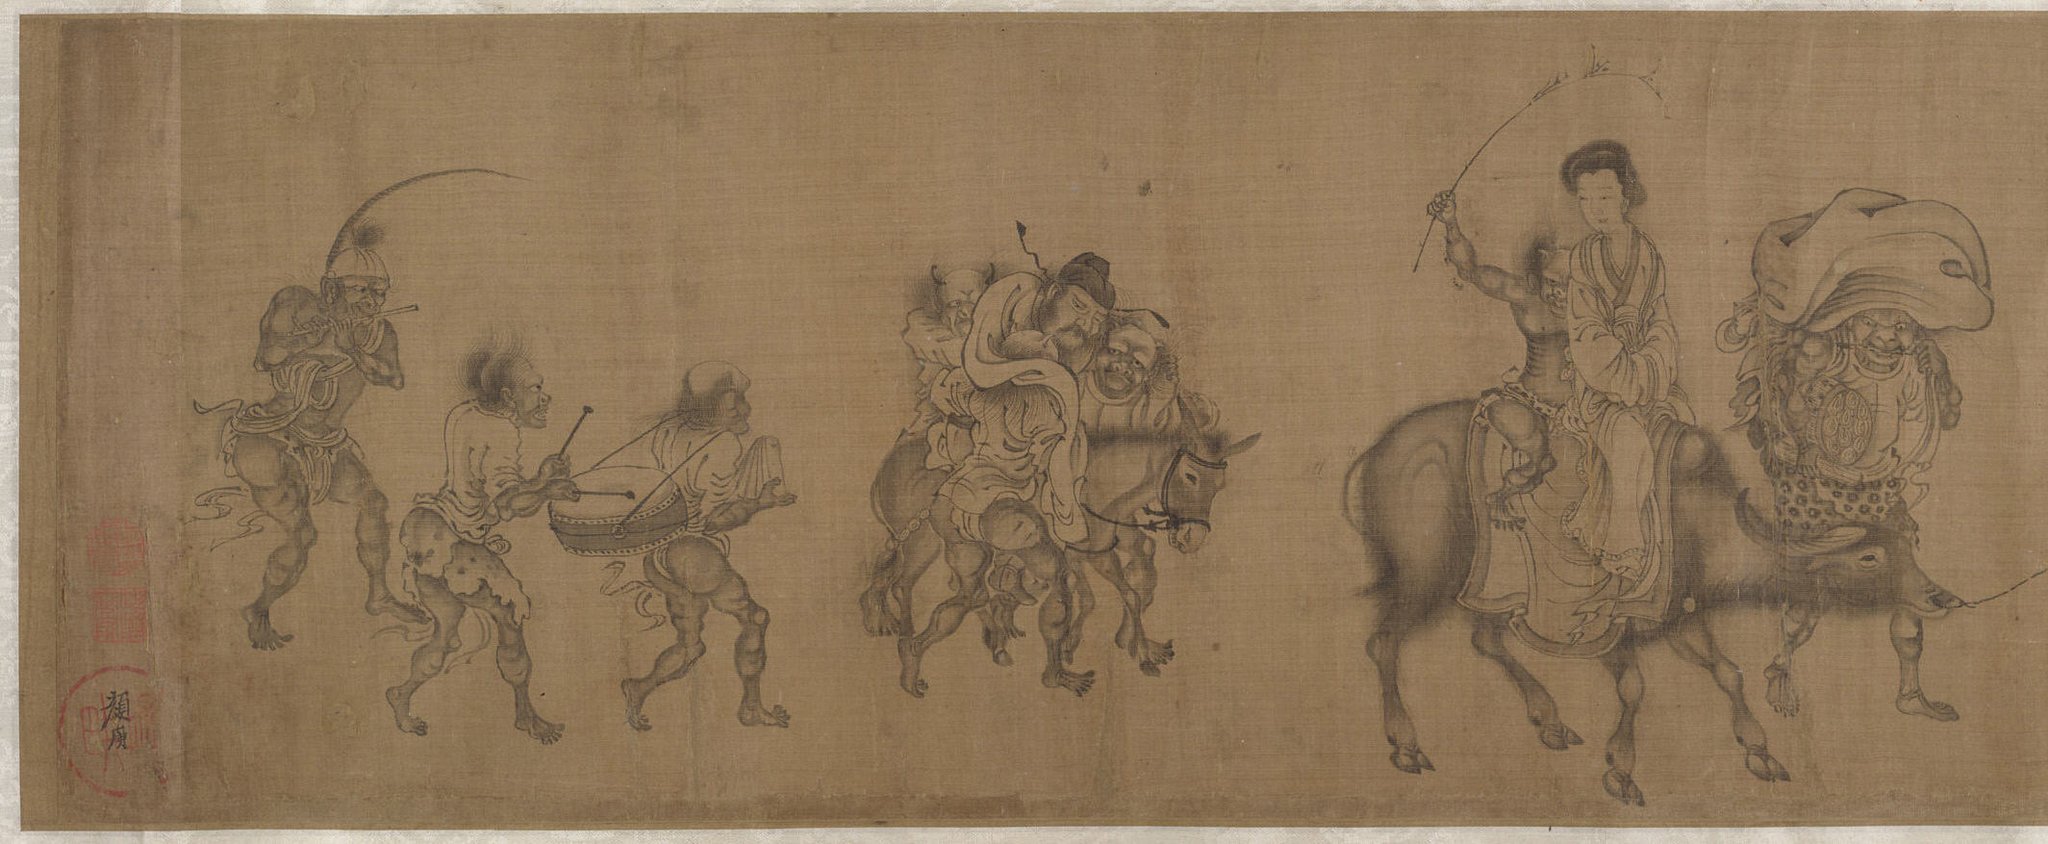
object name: handscroll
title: The Demon Queller Zhong Kui Giving His Sister Away in Marriage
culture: chinese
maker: yan geng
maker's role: artist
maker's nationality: chinese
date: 1271-1368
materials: ink, silk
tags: musical instruments,women,buffalos,donkeys,demons